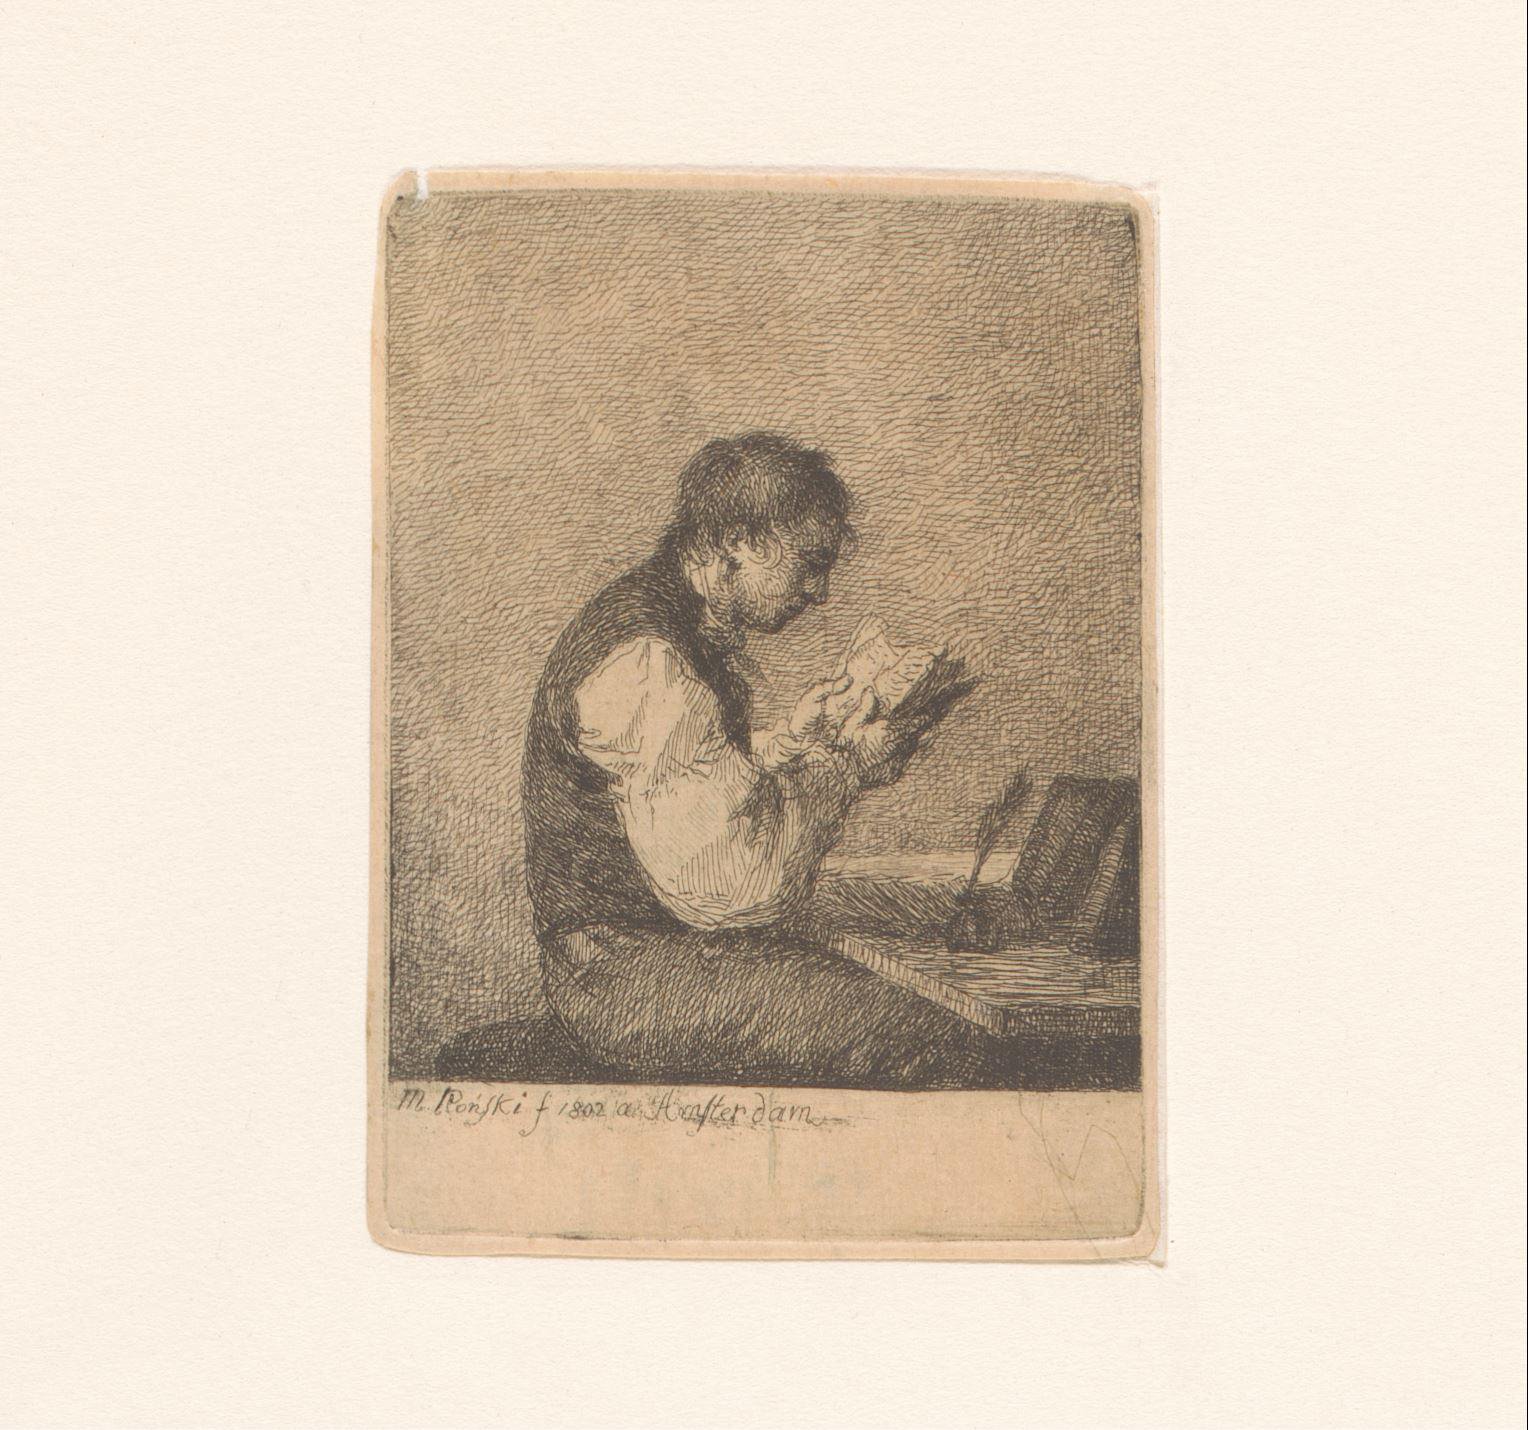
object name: print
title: Veertien etsen van Michał Płoński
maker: michał płoński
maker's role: print maker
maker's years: 1778-1812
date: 1802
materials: paper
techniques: etching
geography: amsterdam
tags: reading, fashion designer, writing accessories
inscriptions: collector's mark: Lugt 2227, collector's mark: Lugt 2228